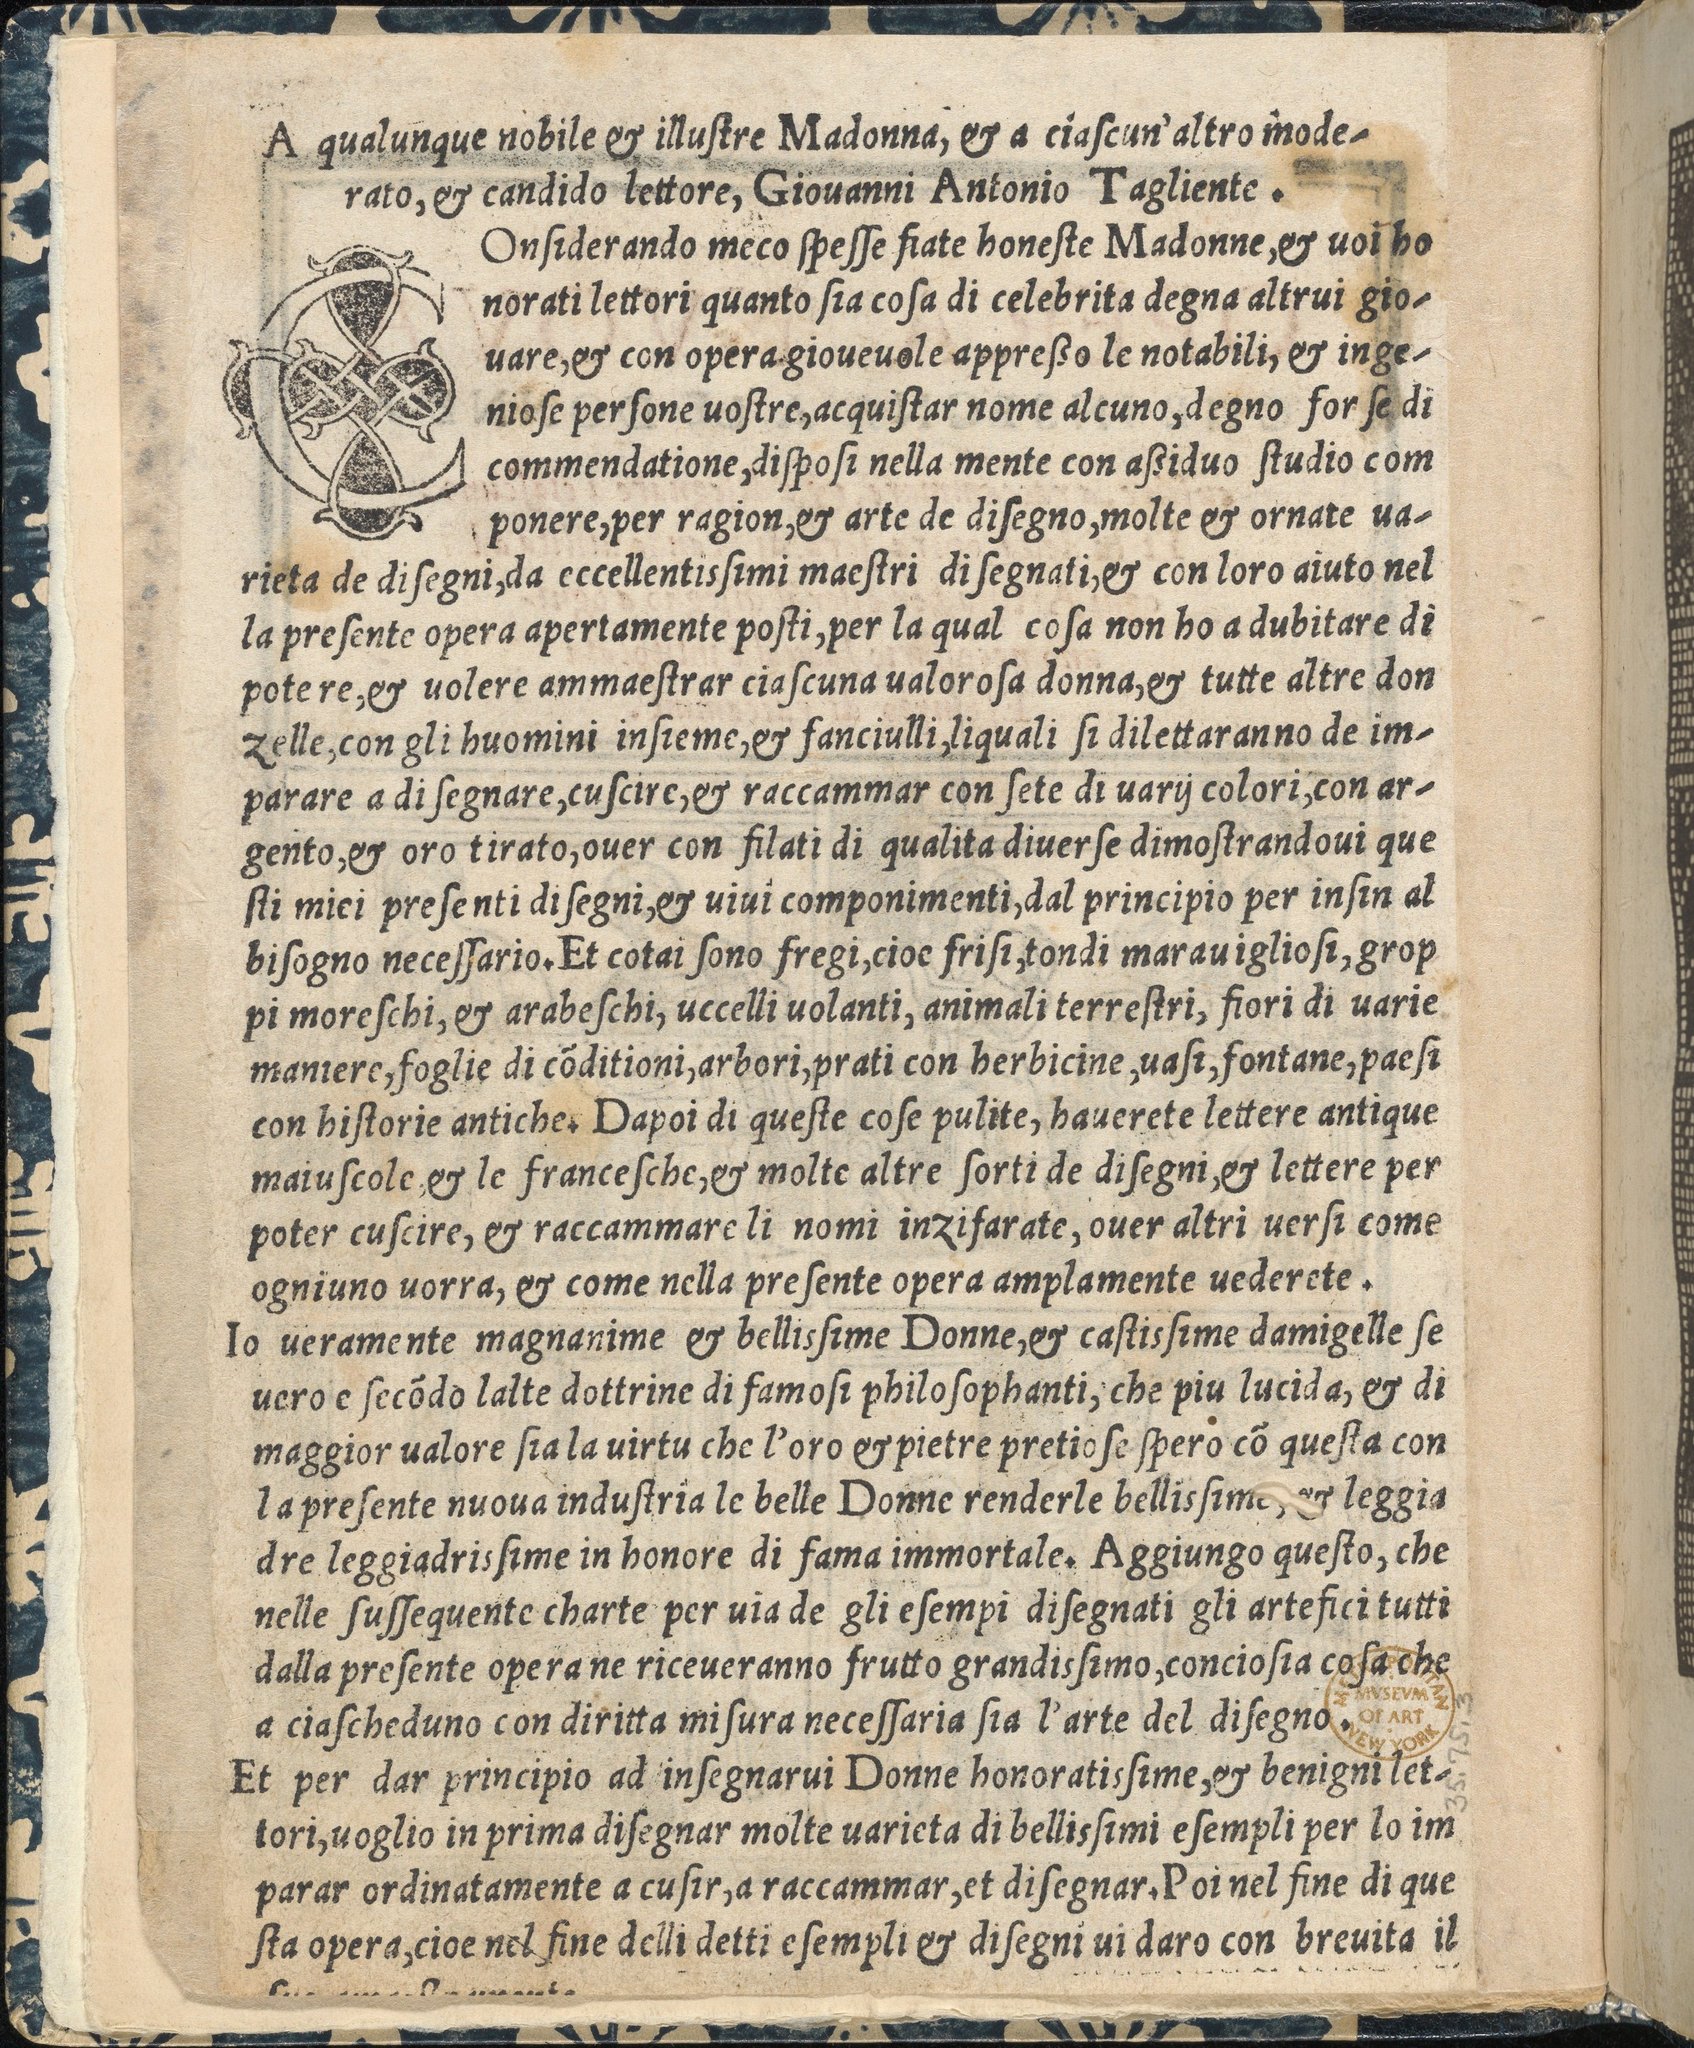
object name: book print ornament architecture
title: Essempio di recammi, title page (verso)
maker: giovanni antonio tagliente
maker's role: author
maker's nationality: italian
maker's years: 1465-1528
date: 1530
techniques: woodcut